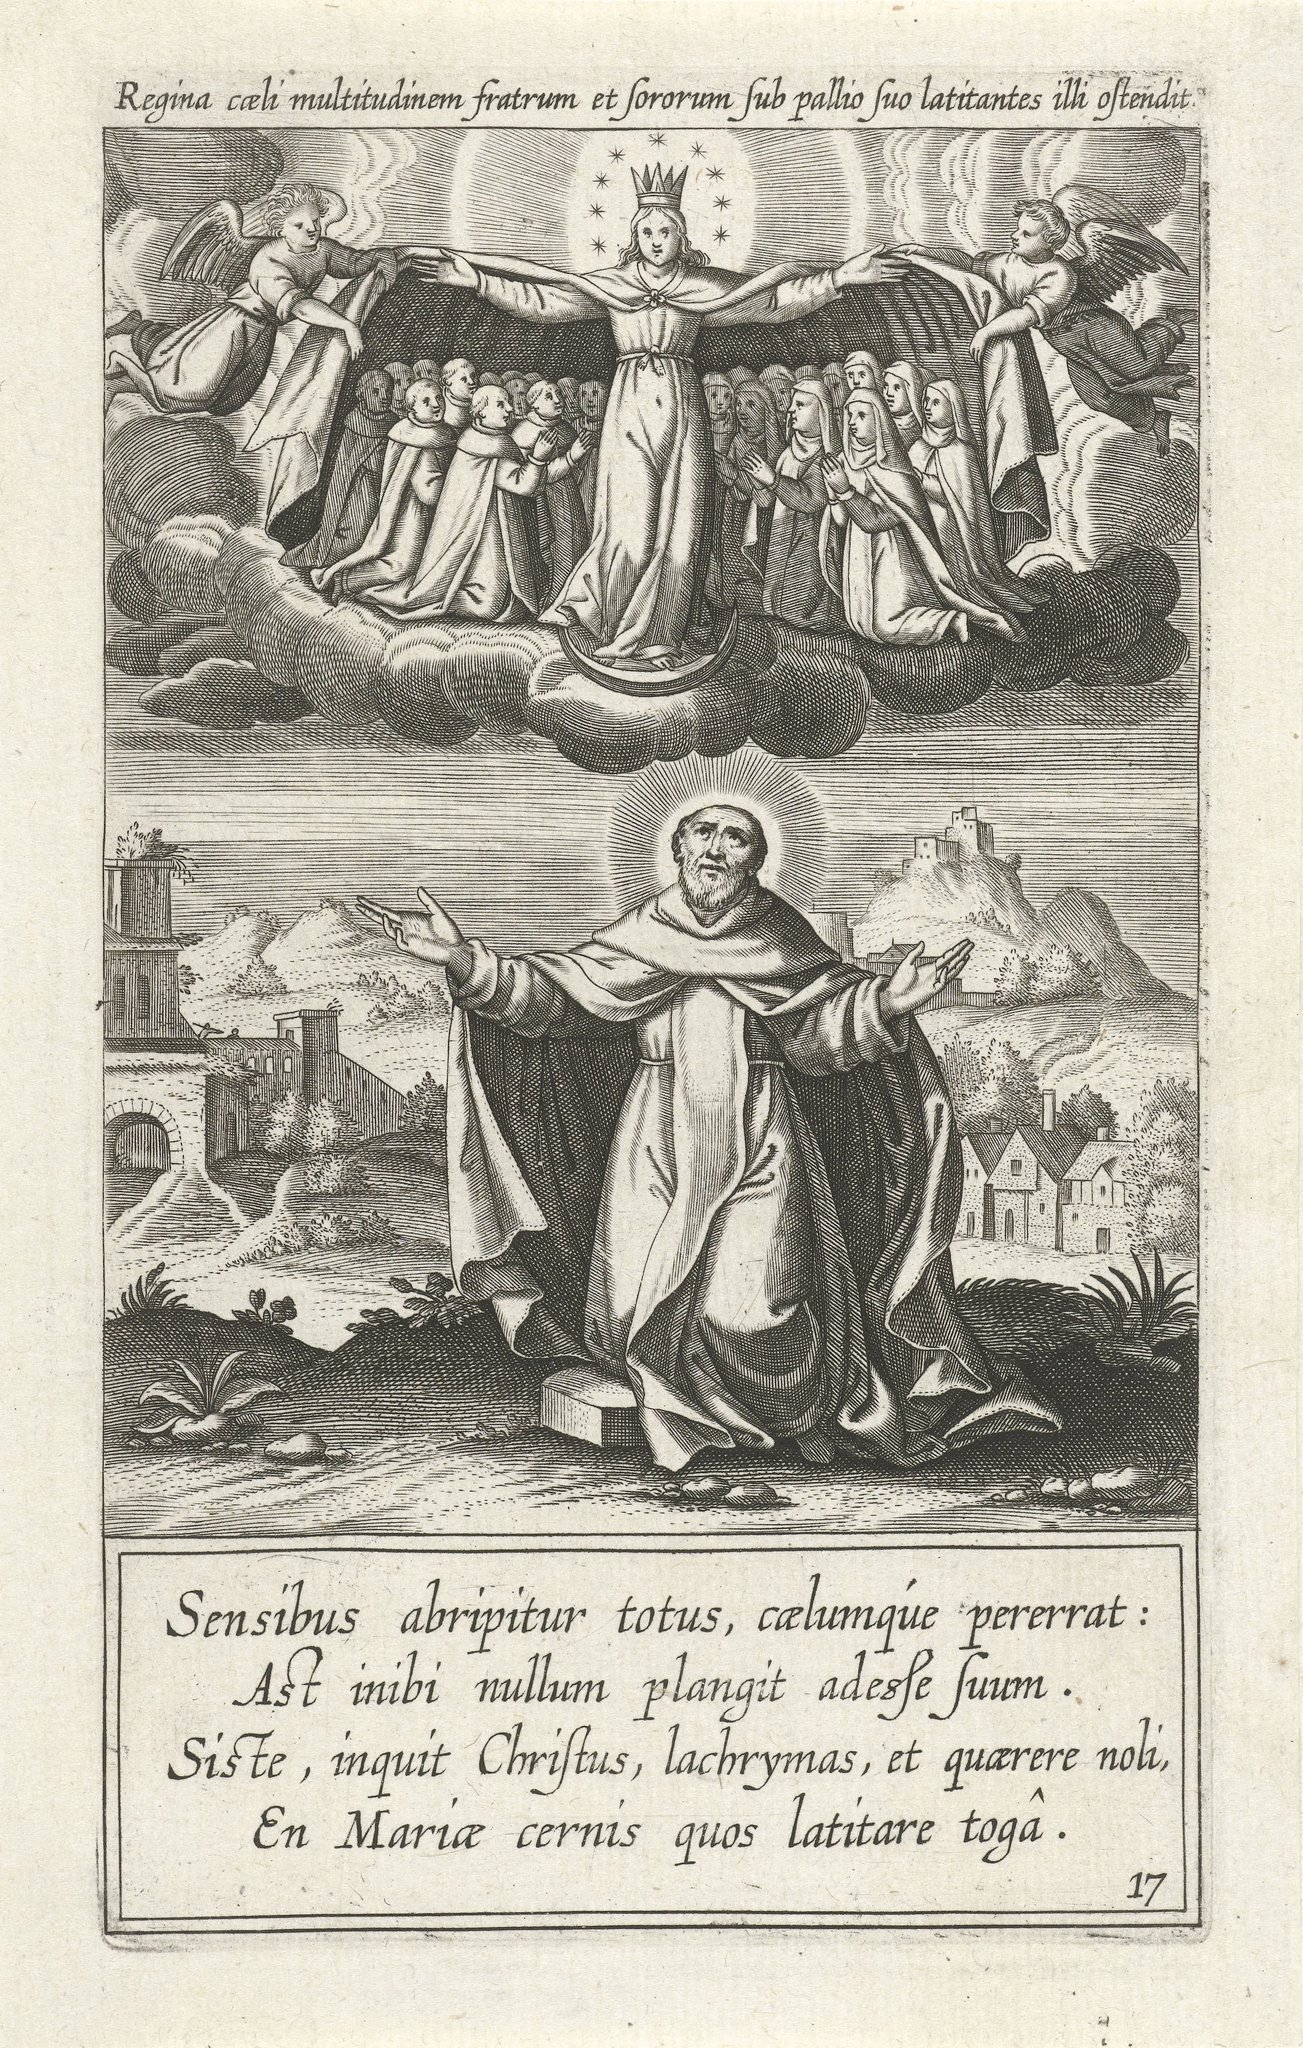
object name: print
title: Visioen van de heilige Dominicus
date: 1611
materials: paper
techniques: engraving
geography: antwerp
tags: visions of st. dominic (+ mary)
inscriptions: collector's mark: Lugt 2228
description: De heilige Dominicus zit geknield op de grond. Hij krijgt een visioen dat de maagd Maria zijn orde beschermt door ze met haar mantel te bedekken. De prent heeft een Latijns opschrift en onderschrift en maakt deel uit van een prentserie voor een boek over het leven van de heilige Dominicus.